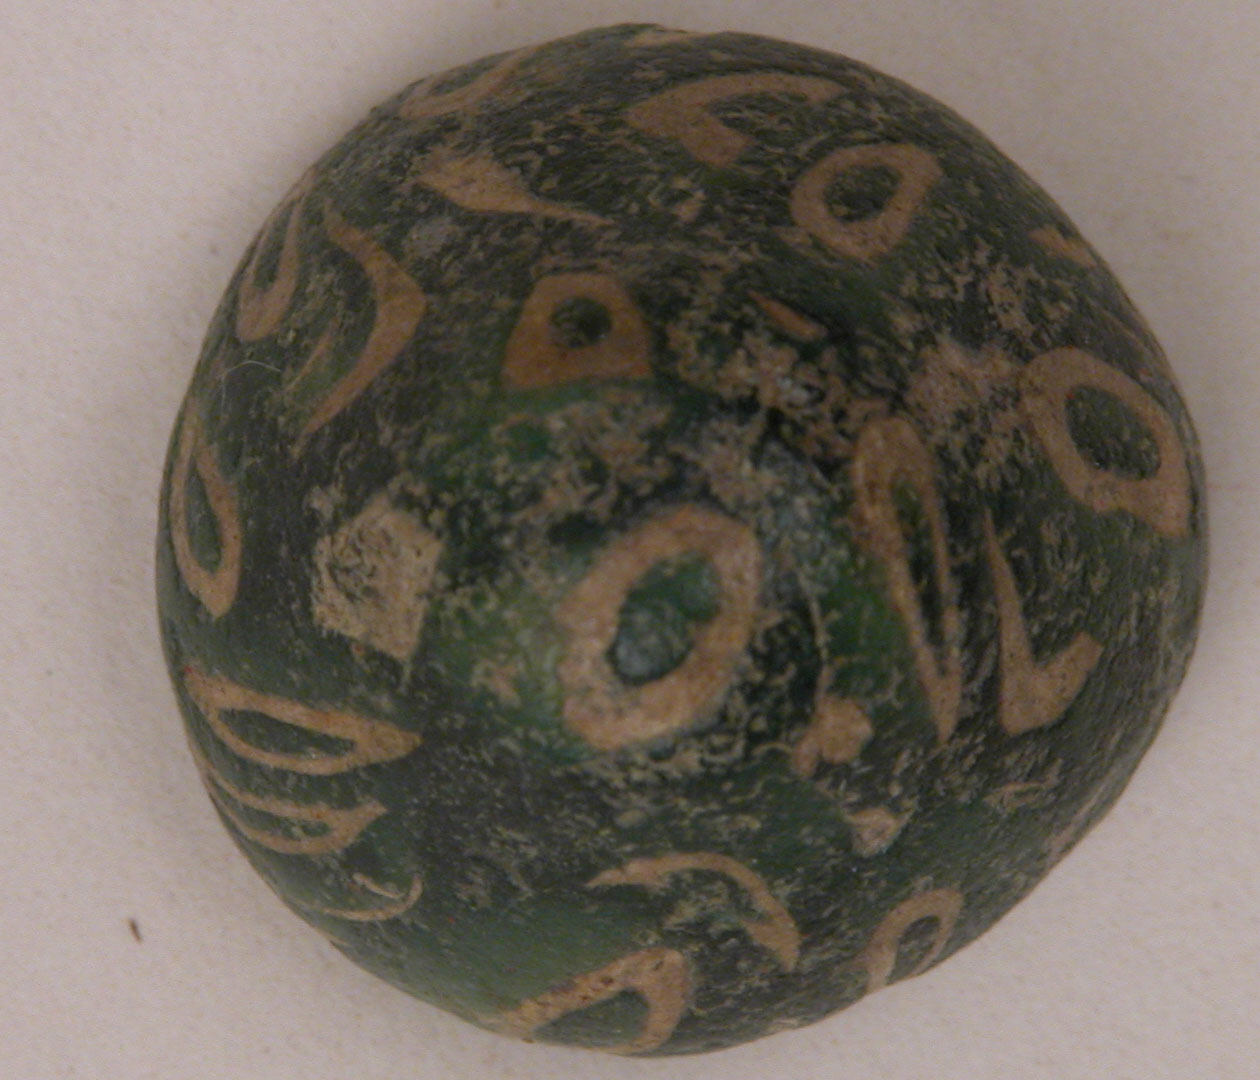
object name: gaming piece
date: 801-1000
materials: glass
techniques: cutting, polish, tooling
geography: islamic lands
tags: games